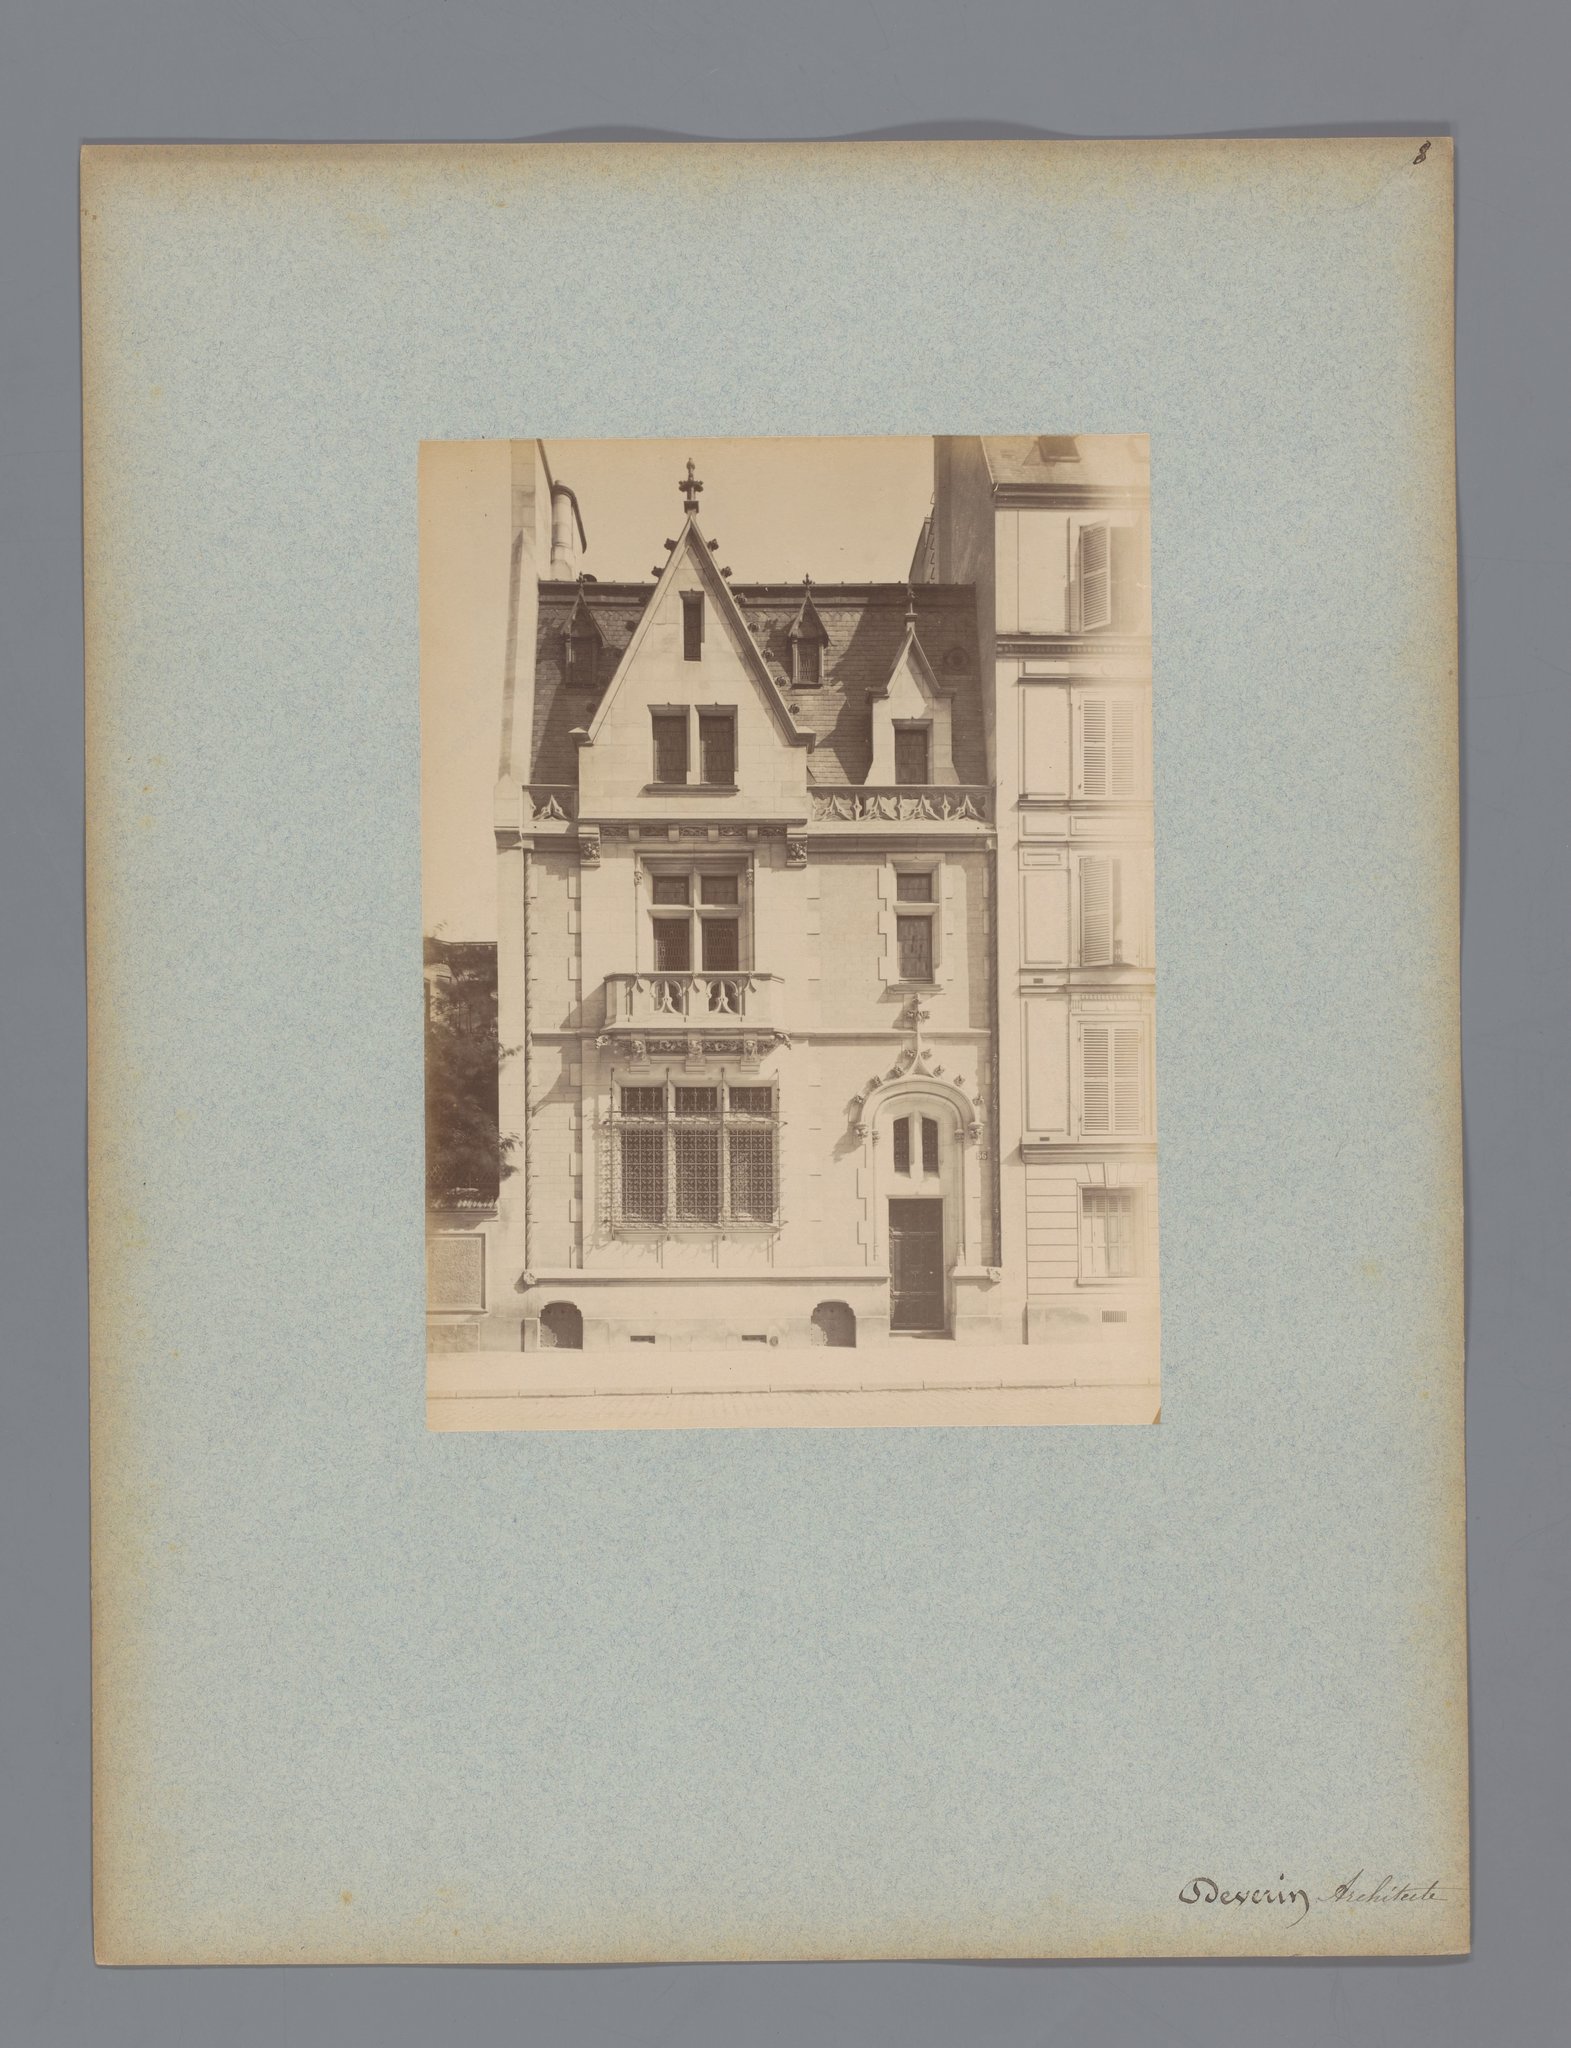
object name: photograph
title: Façade van een woonhuis in Parijs, ontworpen door Henri Deverin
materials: photographic support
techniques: albumen print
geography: paris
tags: urban housing, façade (of house or building), paris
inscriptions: number: ‘8’, name: ‘Deverin Architecte’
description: Deze foto maakt deel uit van een omslag met 35 foto's en een titelblad.